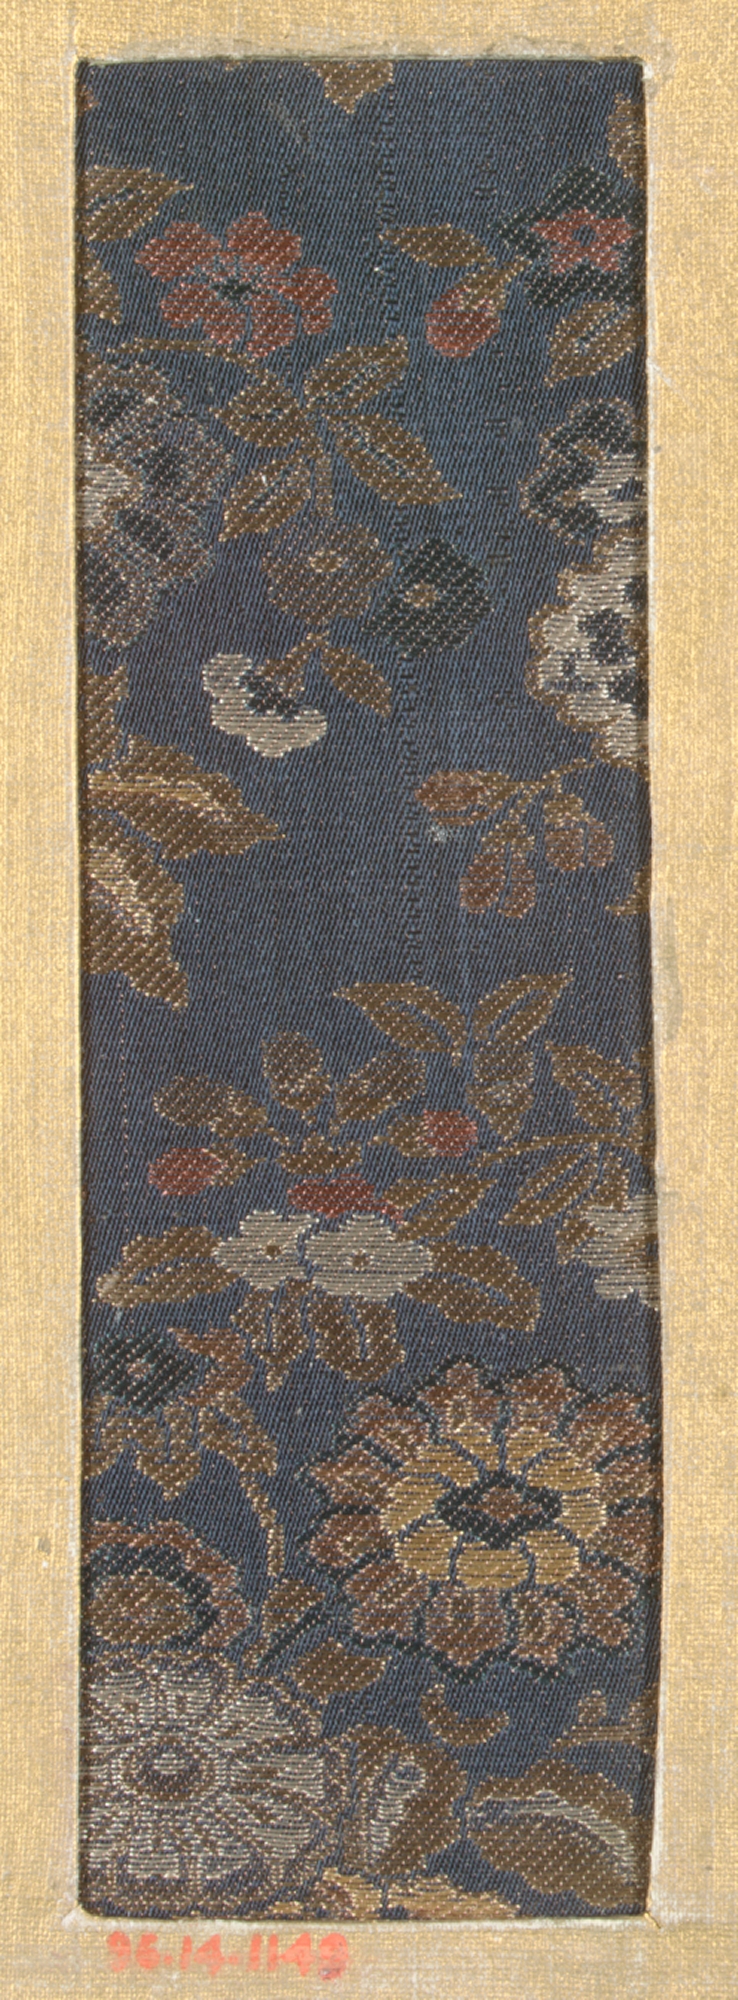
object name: piece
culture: japanese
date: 1701-1900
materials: silk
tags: flowers